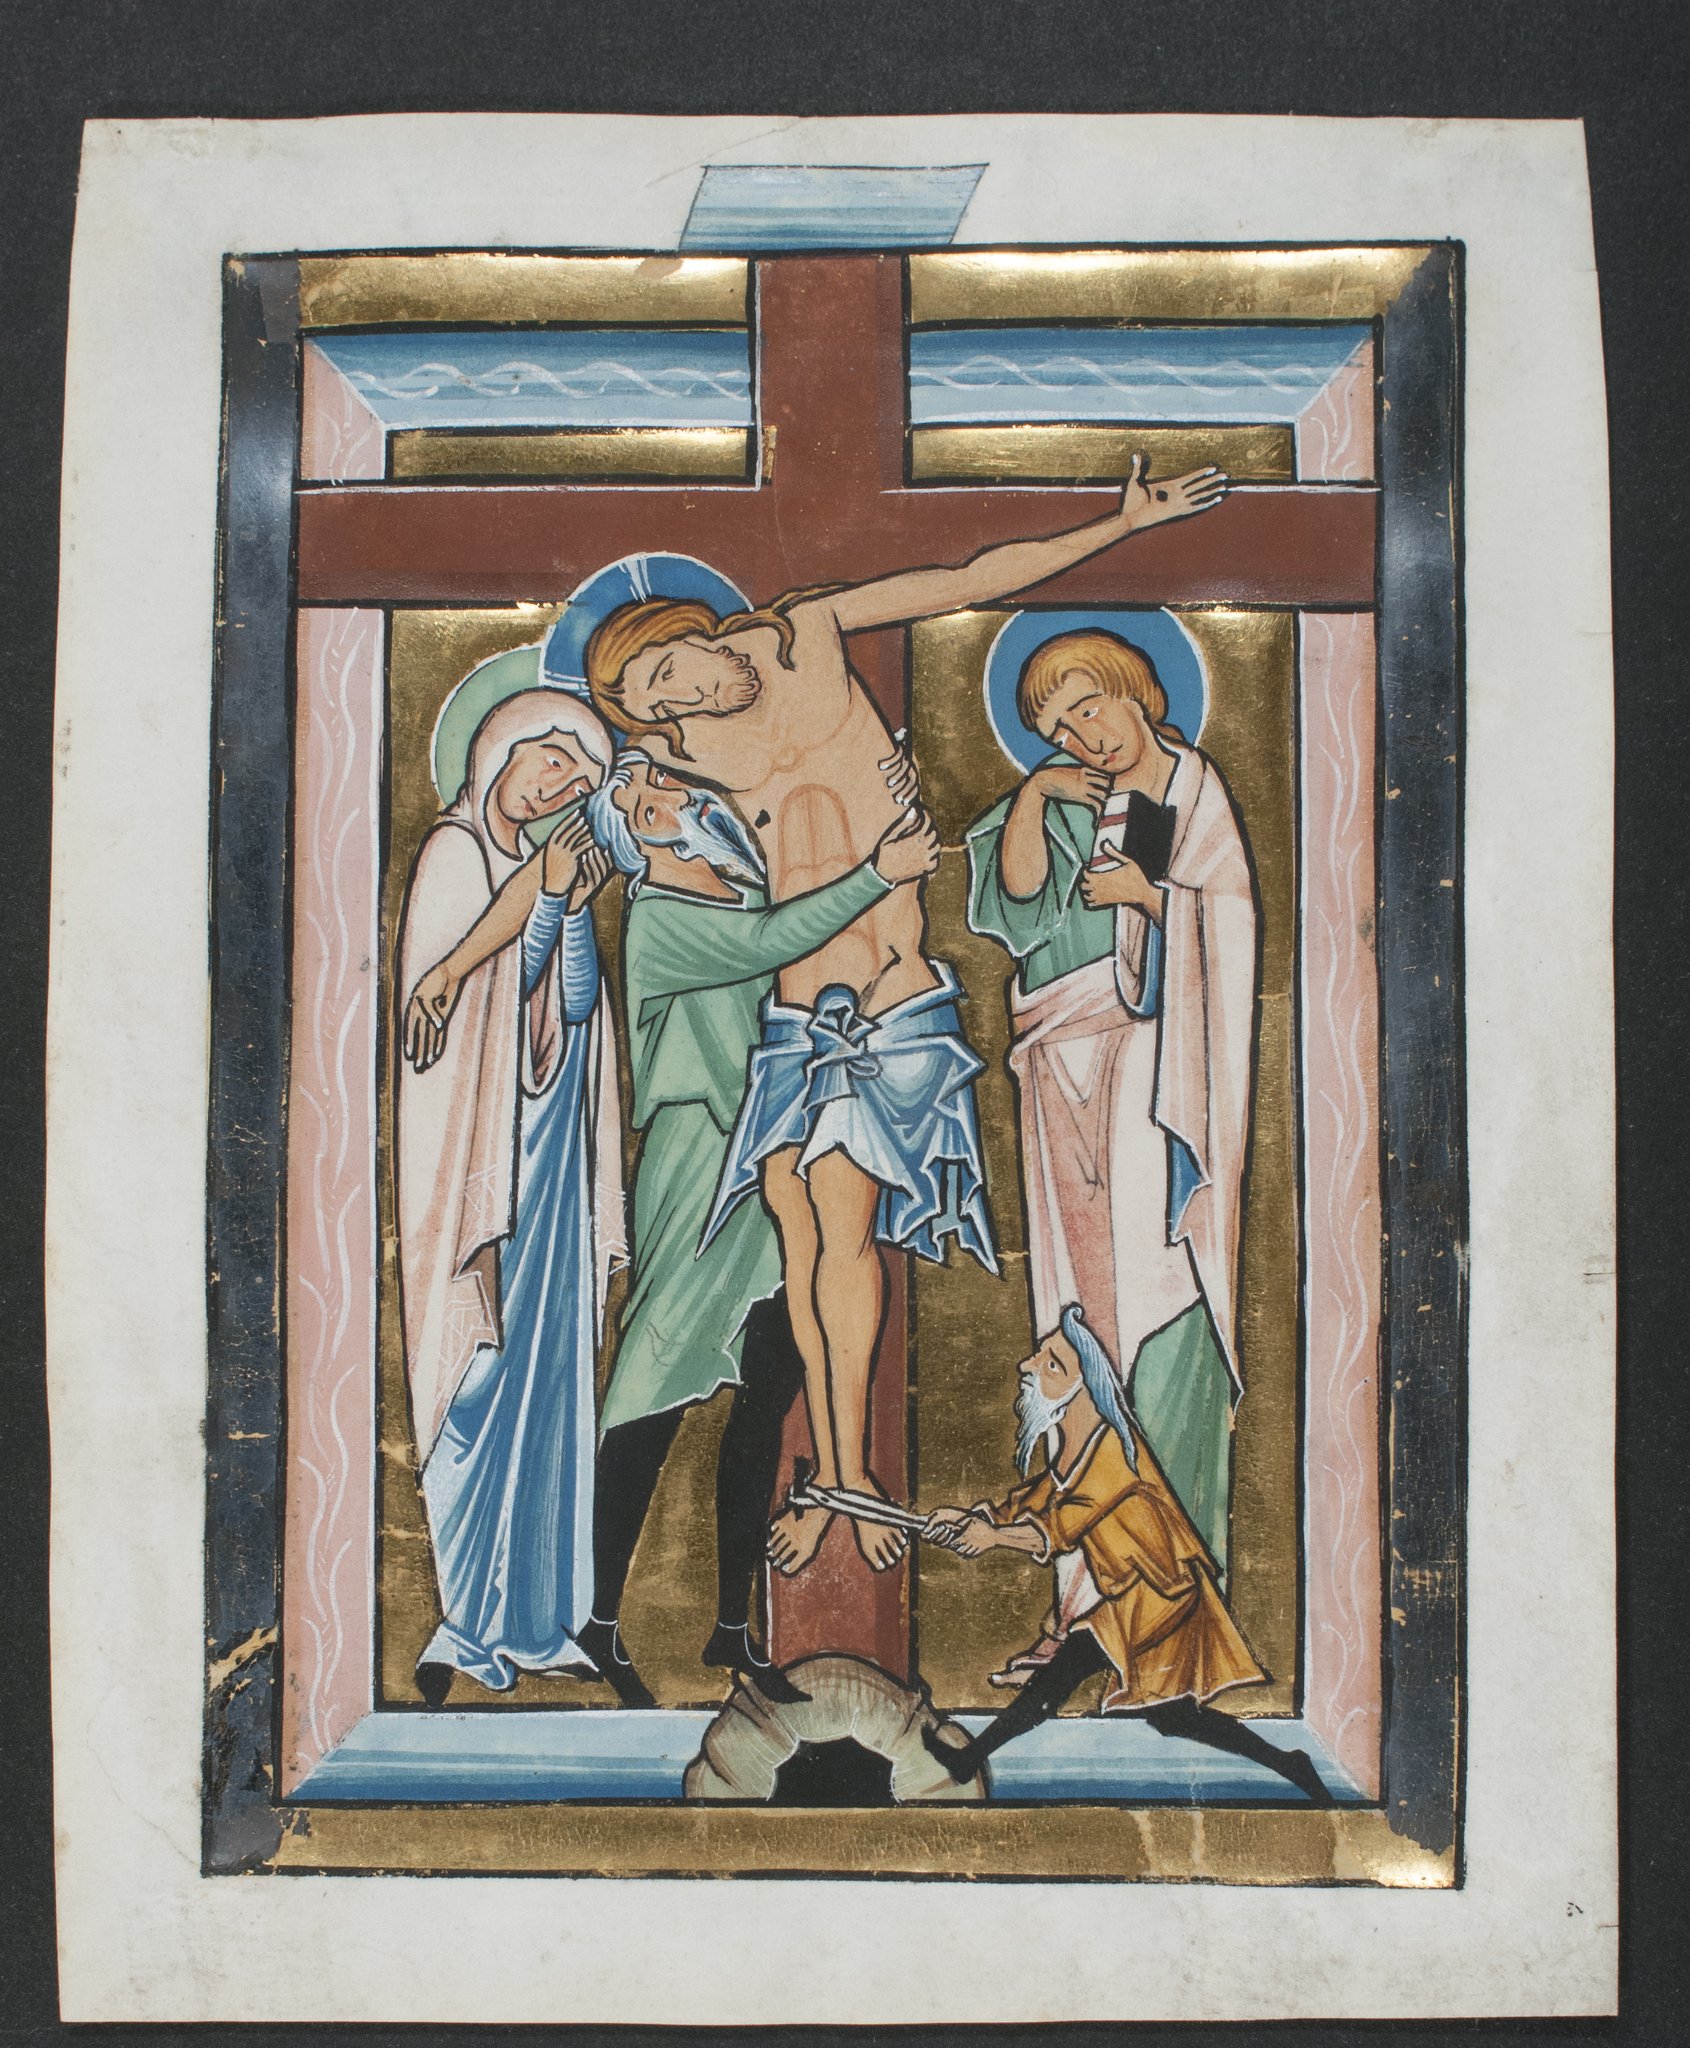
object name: psalter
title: Manuscript Leaf with the Deposition, from a Psalter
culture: german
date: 1234-1266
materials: gold, ink, parchment, silver, paint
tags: christ,virgin mary,crucifixion